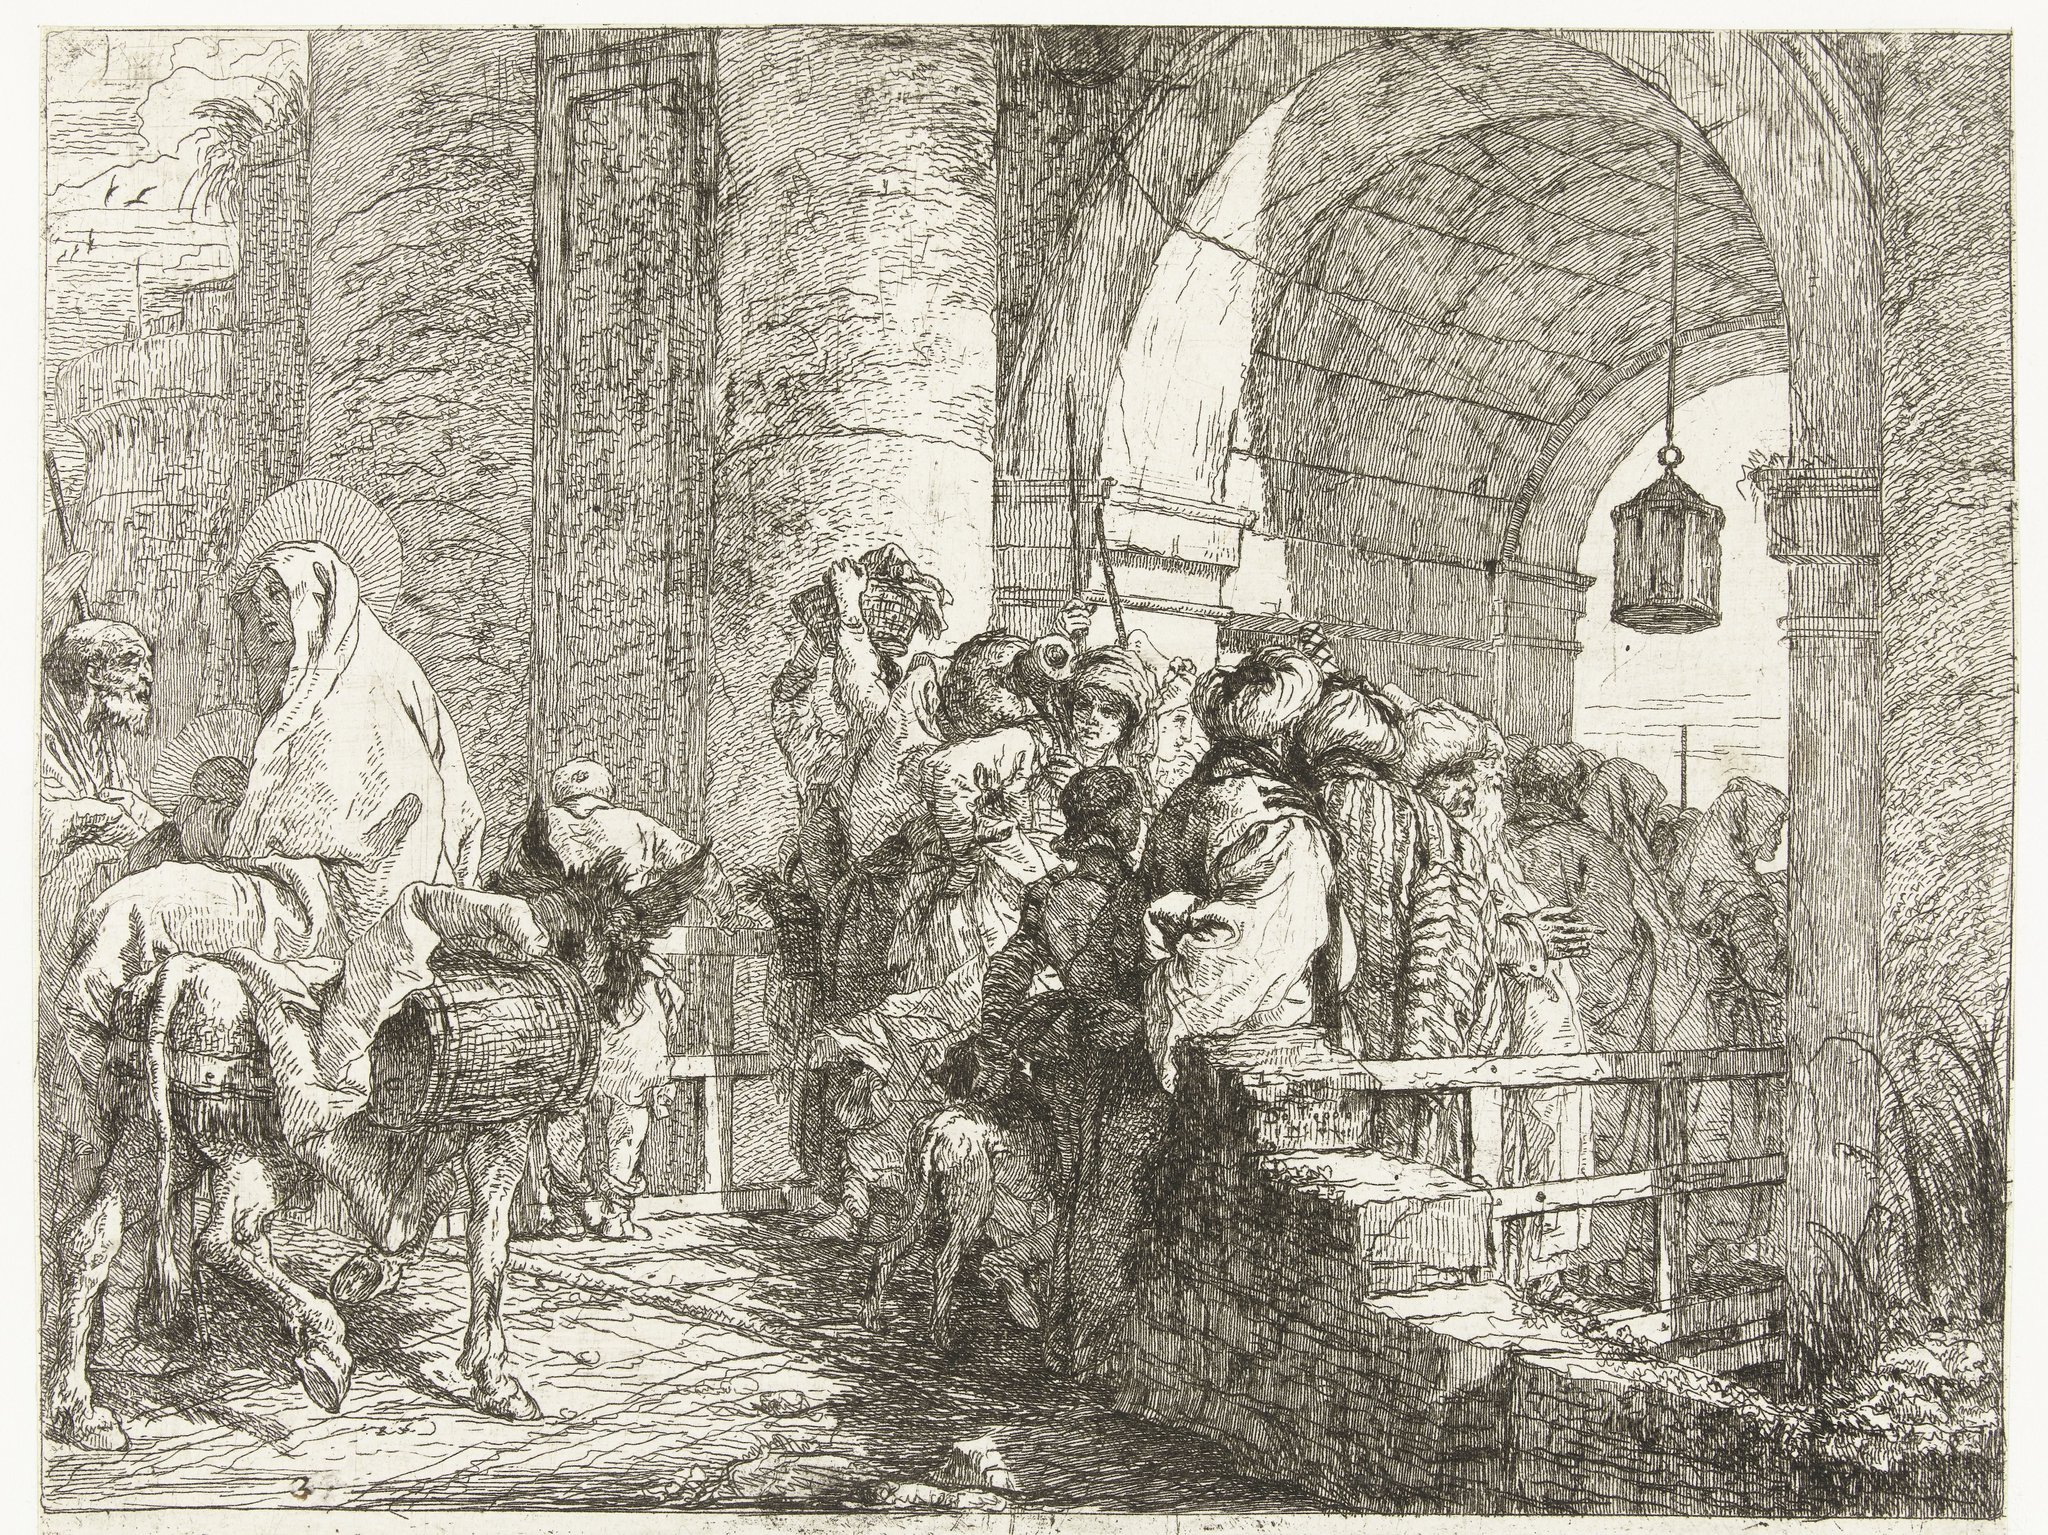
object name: print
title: Vlucht naar Egypte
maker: giovanni domenico tiepolo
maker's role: draughtsman, print maker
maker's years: 1727-1804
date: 1750-1753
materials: paper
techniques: etching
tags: flight into egypt and miracles during the journey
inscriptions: collector's mark: Lugt 2228, collector's mark: Lugt 2760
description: Prent uit serie van zevenentwintig prenten met de Vlucht naar Egypte. Op de prent is het nummer 27 gedeeltelijk verwijderd en met pen in bruin het cijfer 2 gewijzigd in een 3.